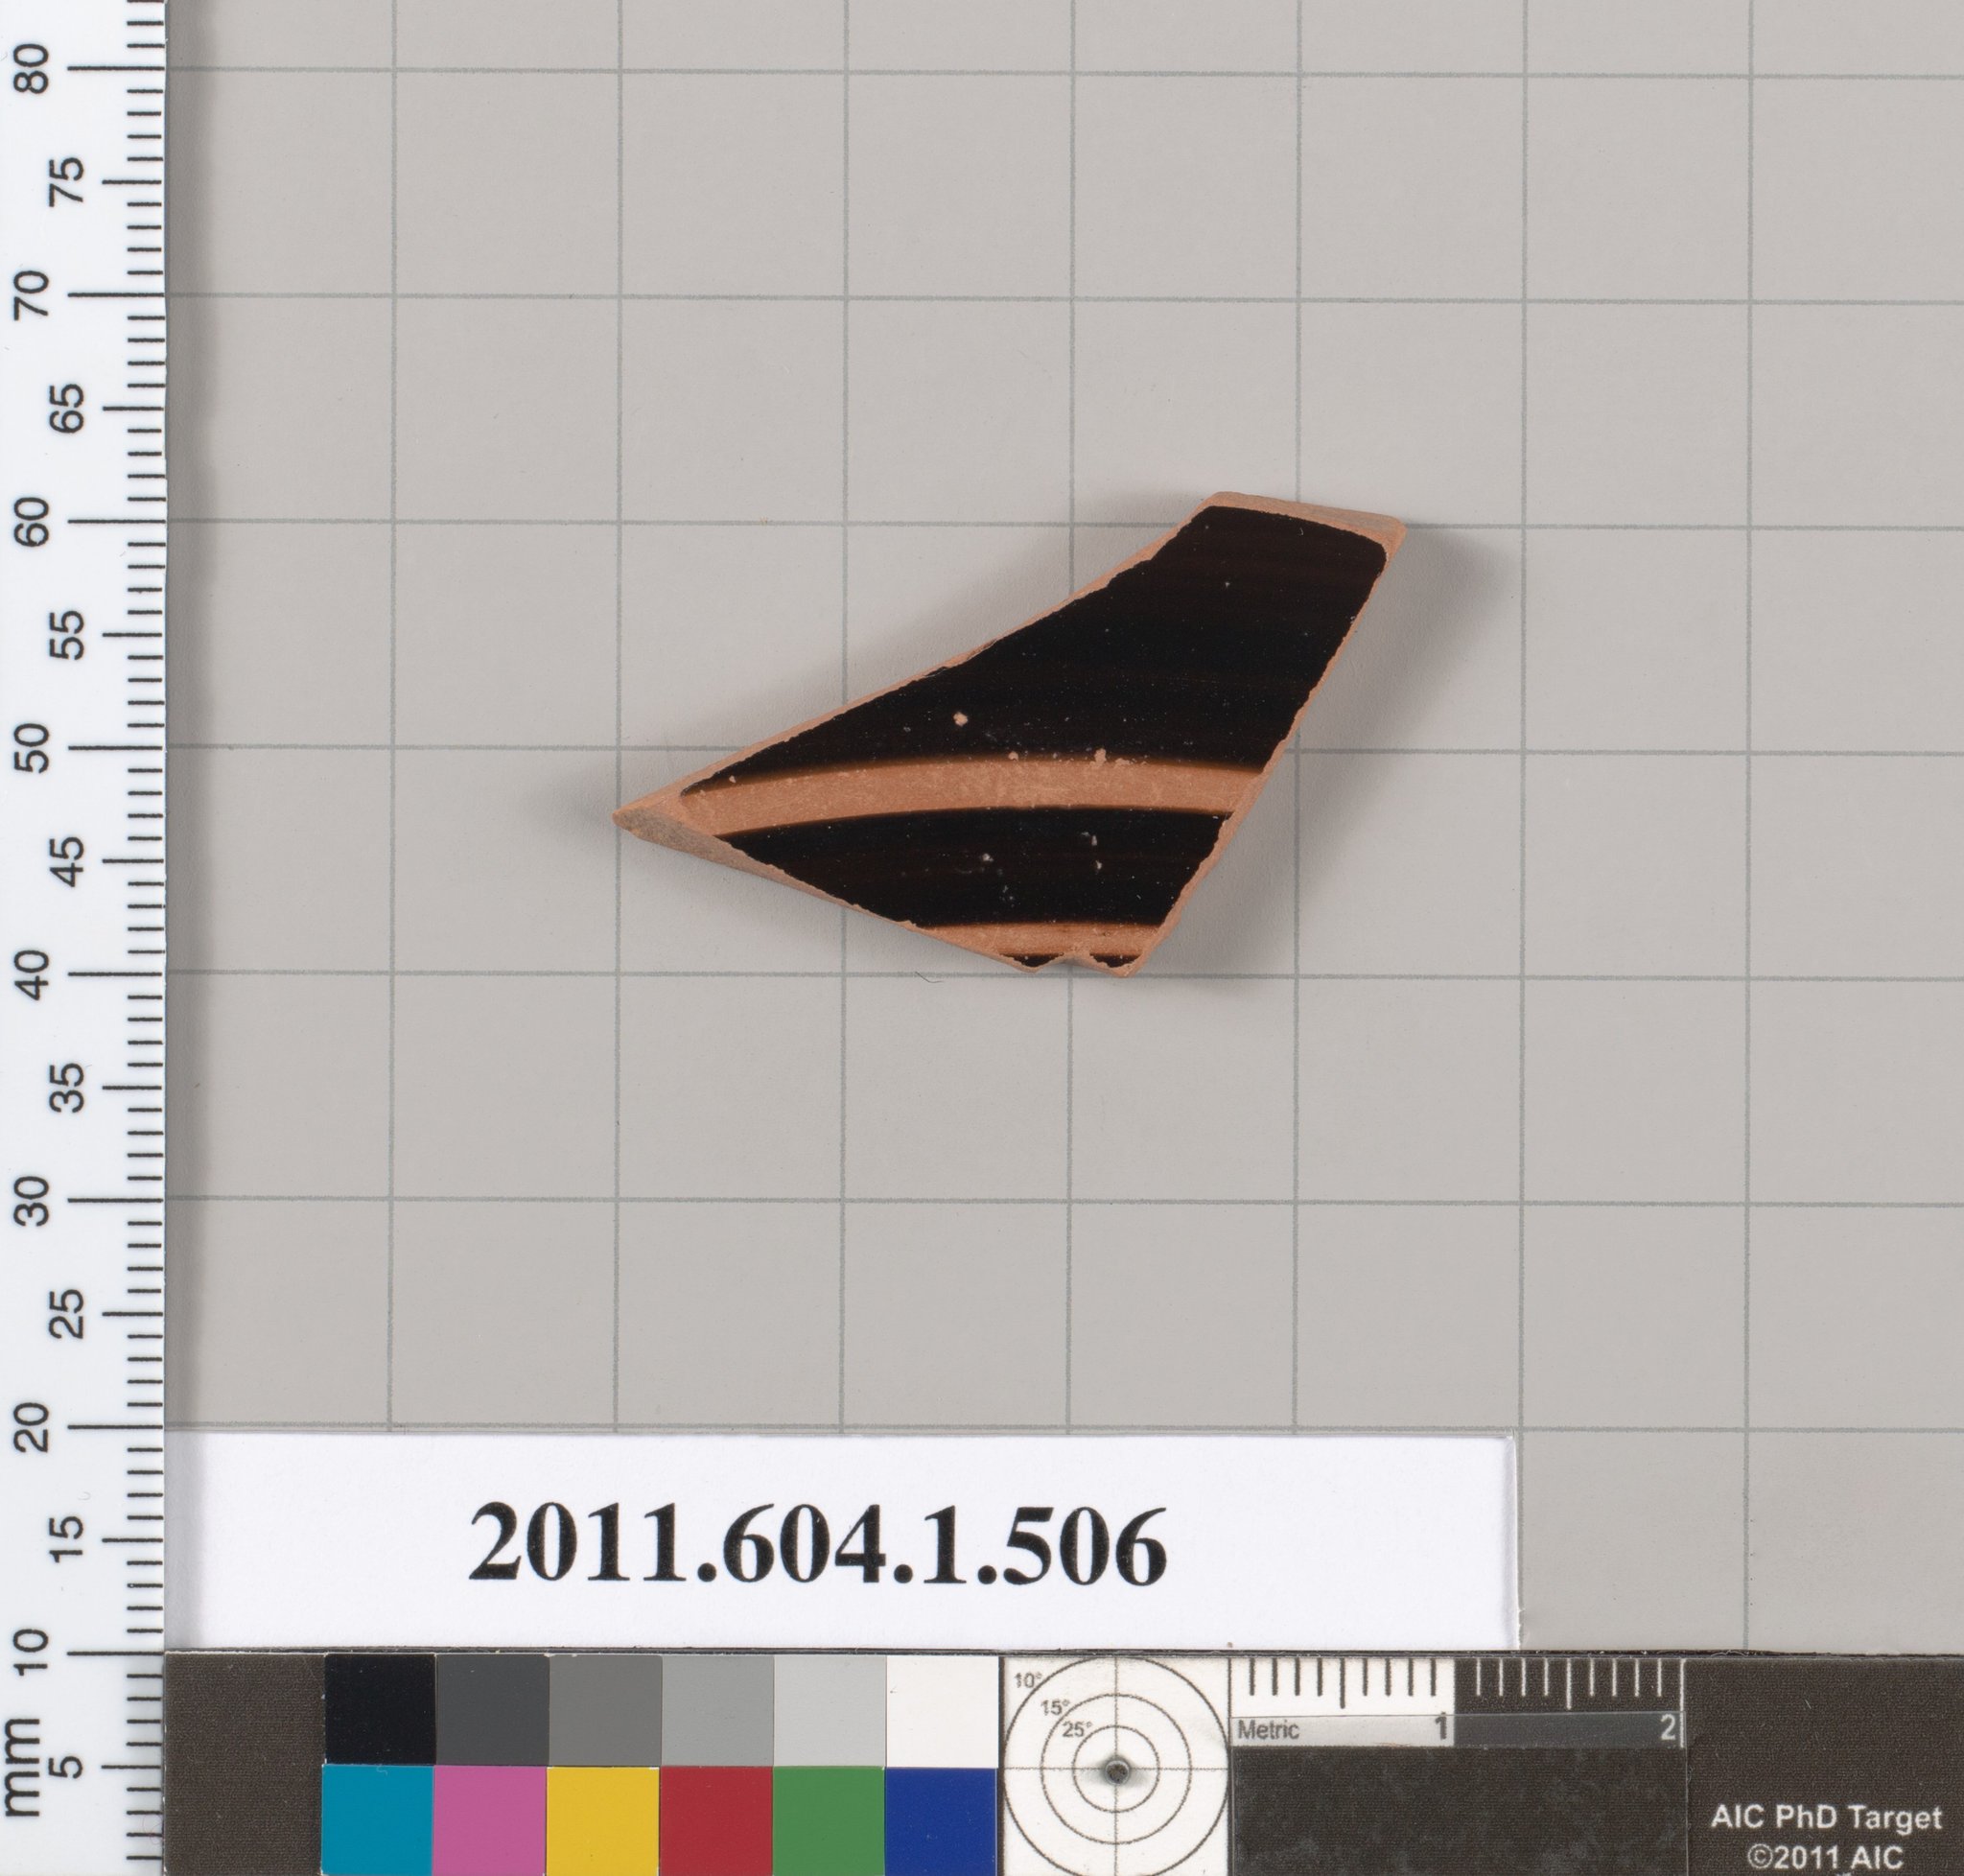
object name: kylix fragment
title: Terracotta fragment of a kylix (drinking cup)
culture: greek, attic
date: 490-480 BCE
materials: terracotta